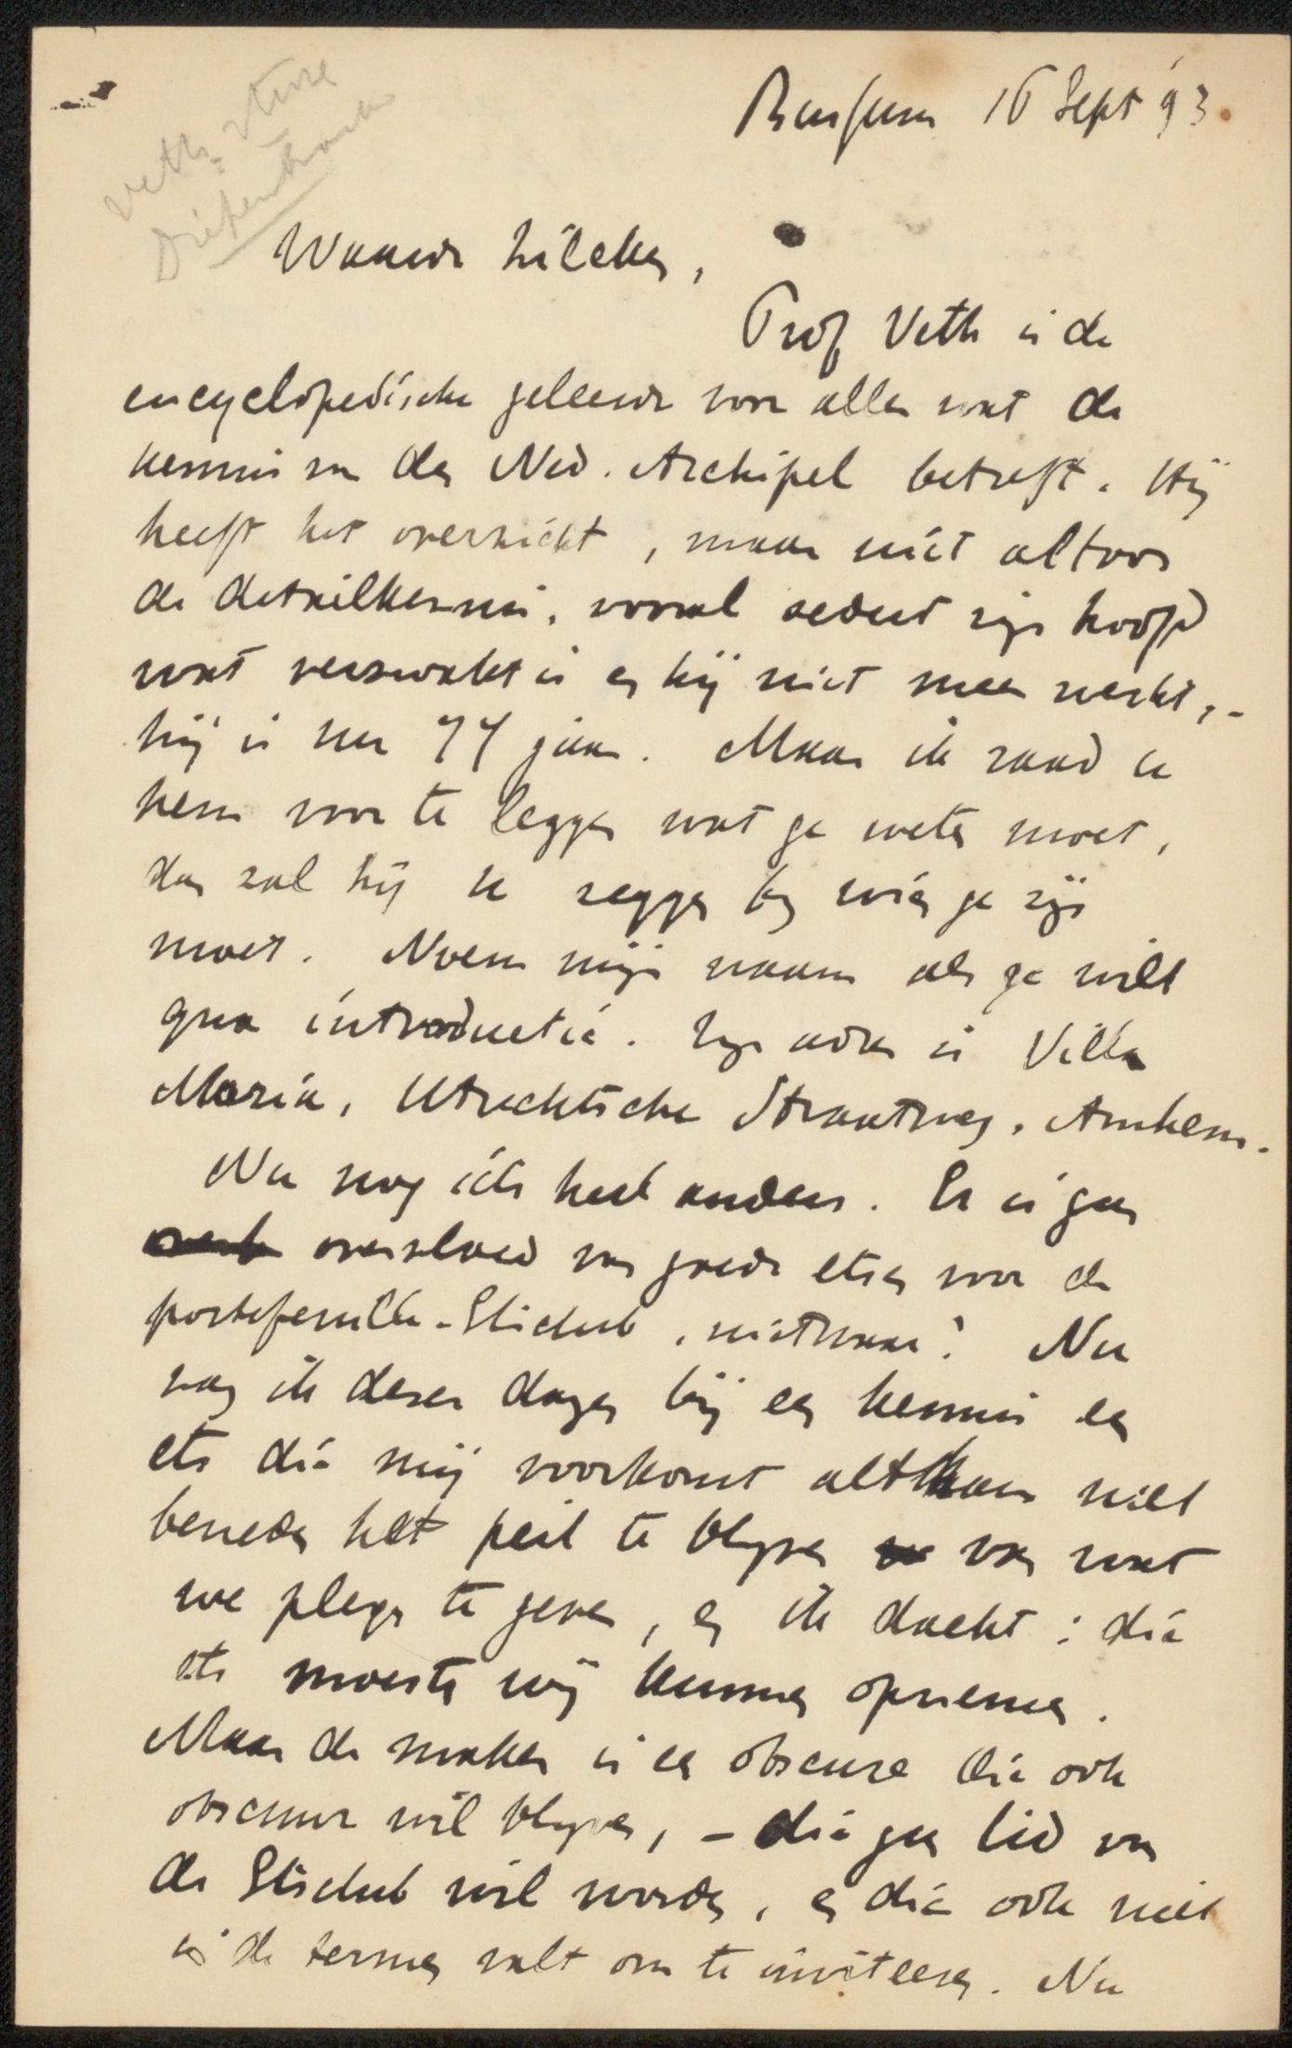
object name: letter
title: Brief aan Philip Zilcken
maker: jan veth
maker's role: designer, draughtsman, painter, print maker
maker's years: 1864-1925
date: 1893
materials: ink, paper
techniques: pen, writing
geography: brussels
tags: marius bauer, the hague, philip zilcken, the graphic arts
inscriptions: watermark, collector's mark: ‘RPK’